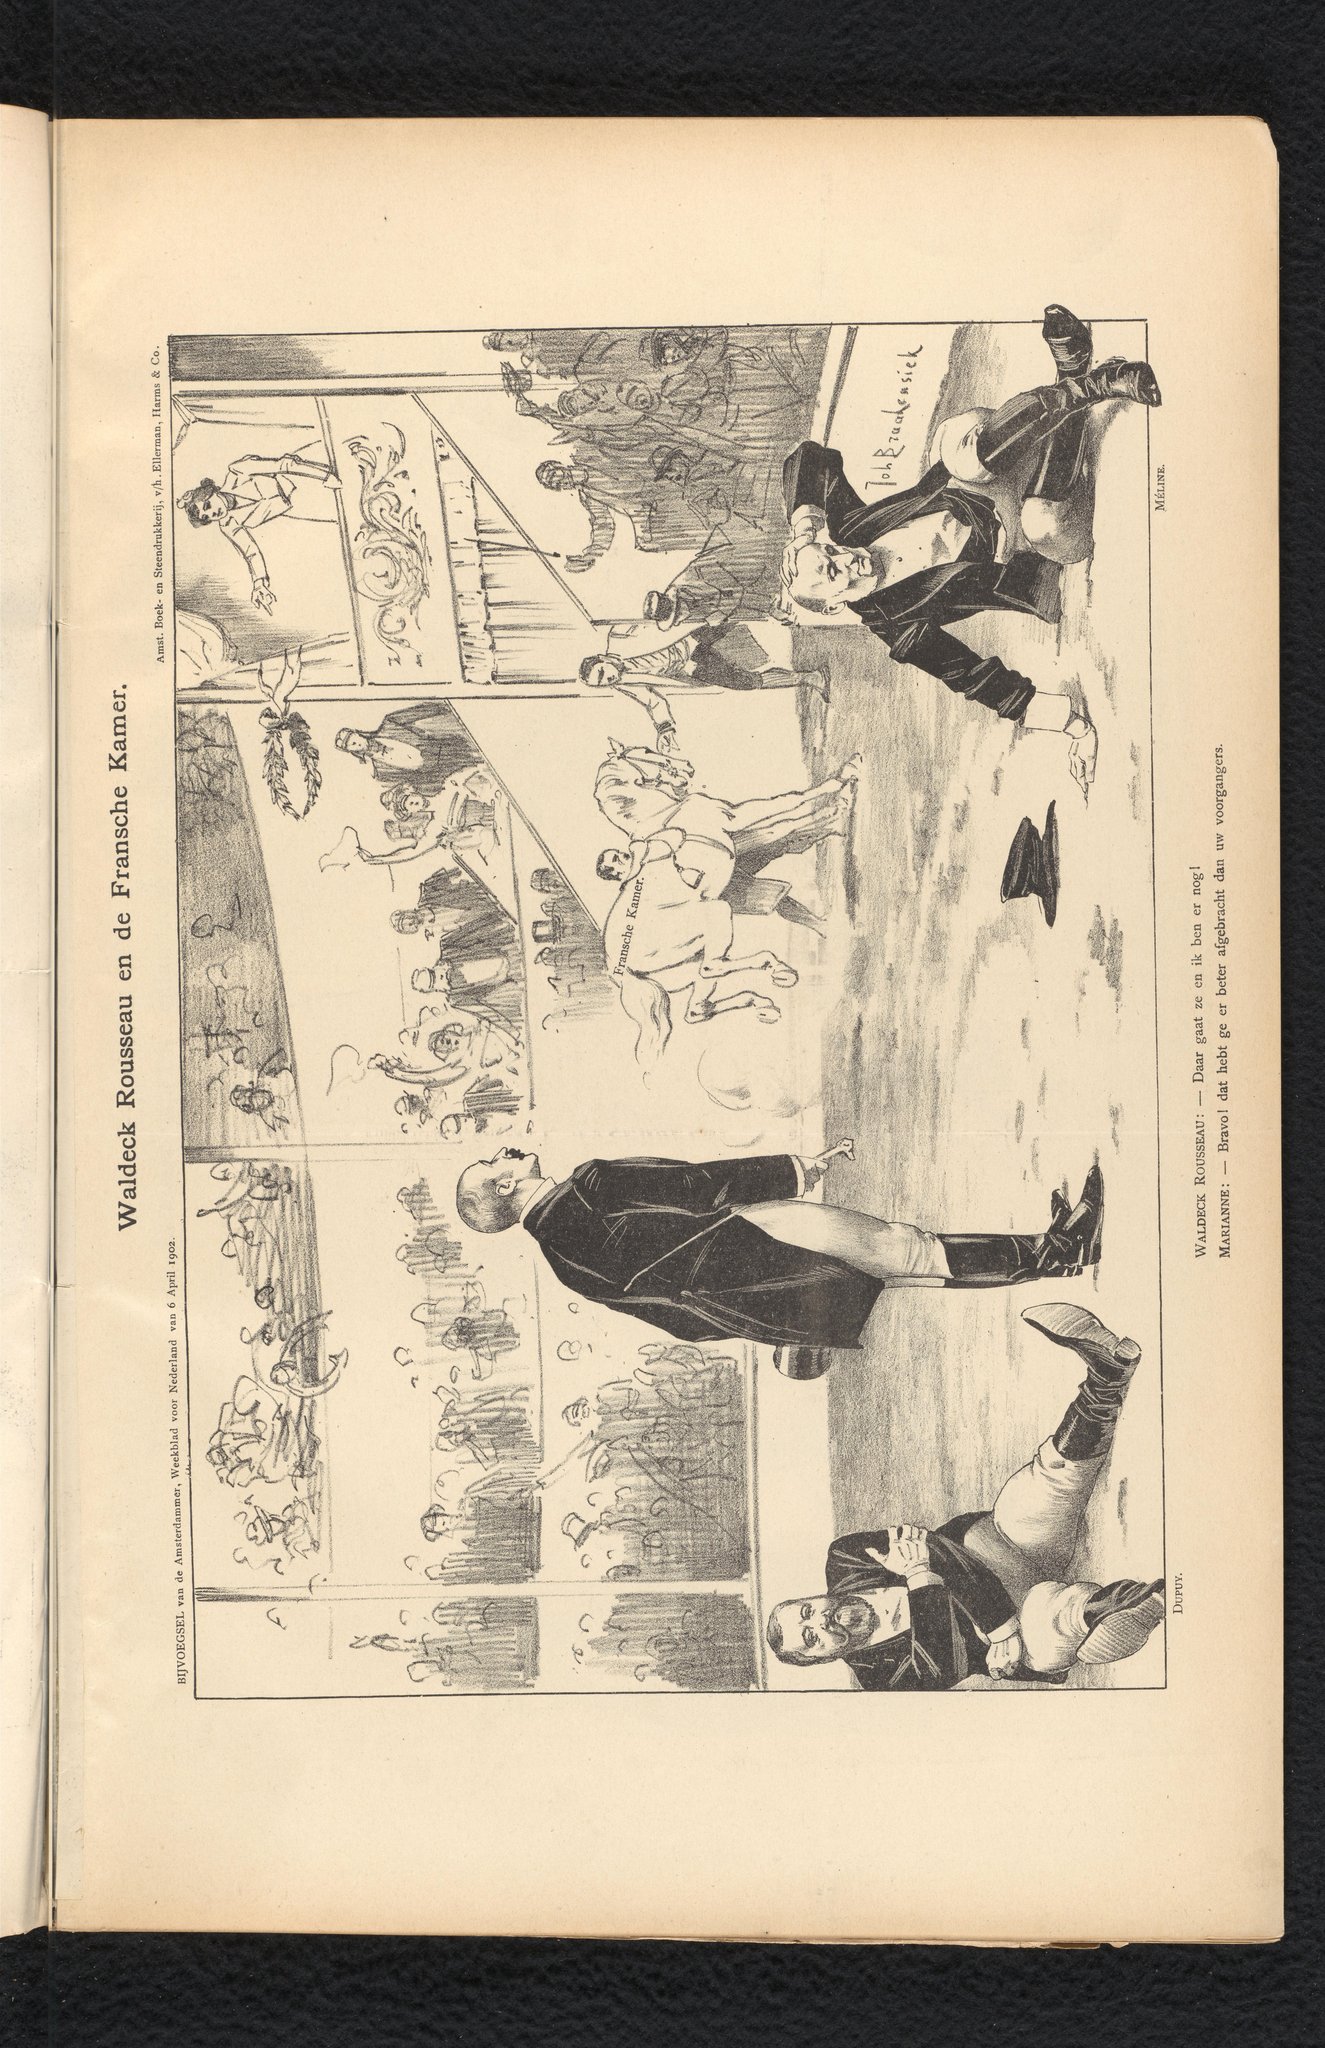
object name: cartoon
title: Waldeck Rousseau en de Fransche Kamer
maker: johan braakensiek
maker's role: draughtsman, print maker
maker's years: 1858-1940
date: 1902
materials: paper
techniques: lithograph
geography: amsterdam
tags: personifications of countries, nations, states, districts, etc., horses (circus performance), circus ring, political caricatures and satires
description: De Franse premier René Waldeck-Rousseau als circusdirecteur ziet dat het paard, het Franse parlement, berijders van zich afwerpt.